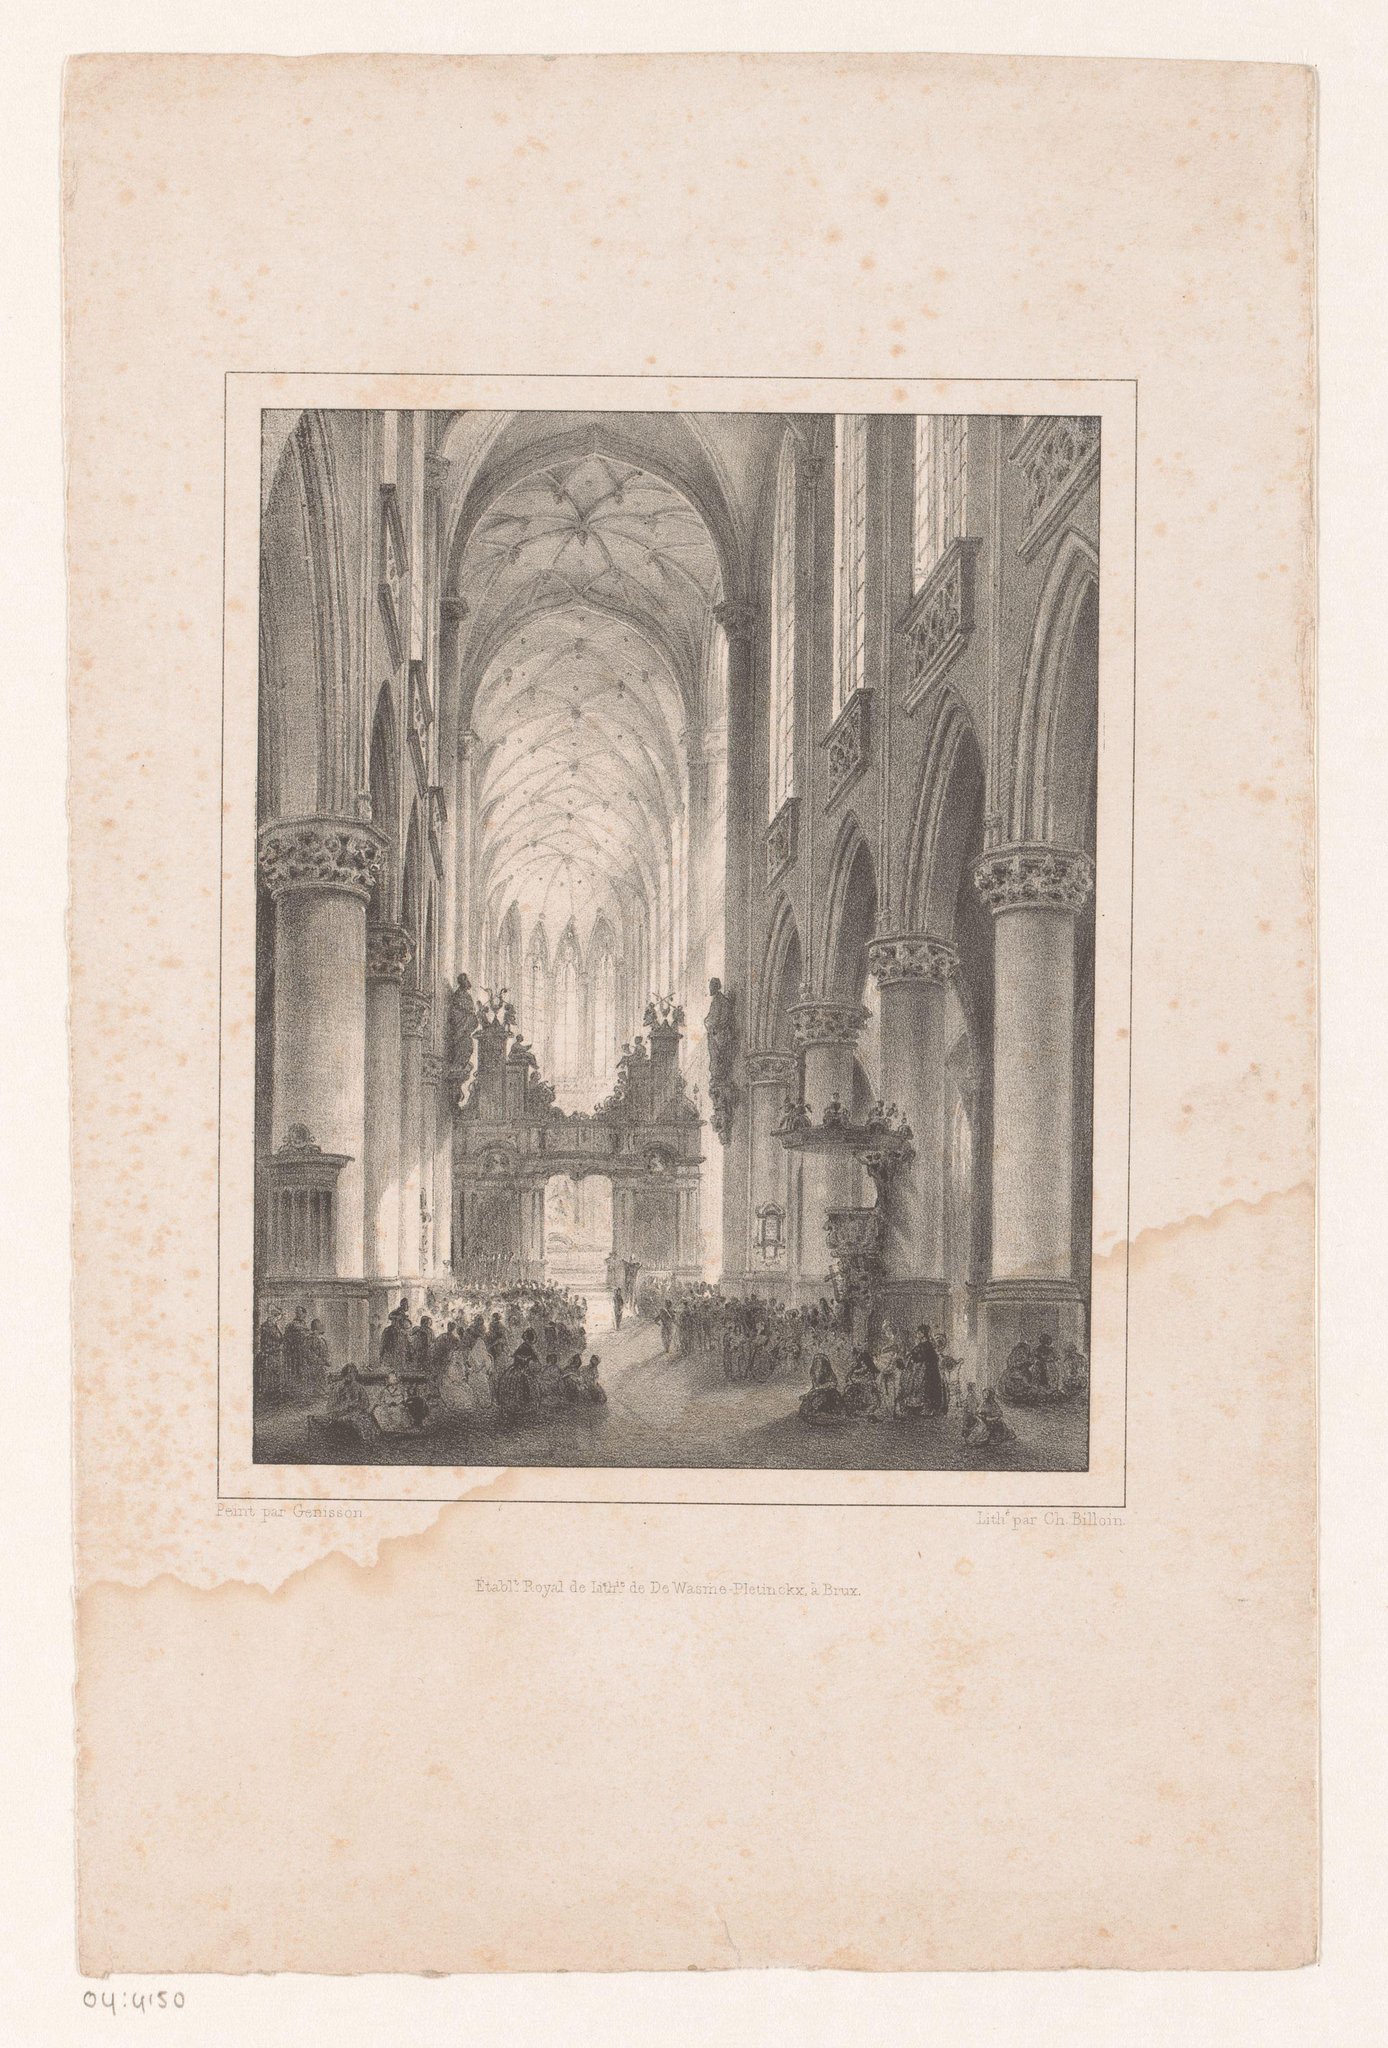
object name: print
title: Interieur van een kerk te Antwerpen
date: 1827-1851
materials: paper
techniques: lithograph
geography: brussels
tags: interior of church, antwerp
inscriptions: collector's mark: Lugt 2228